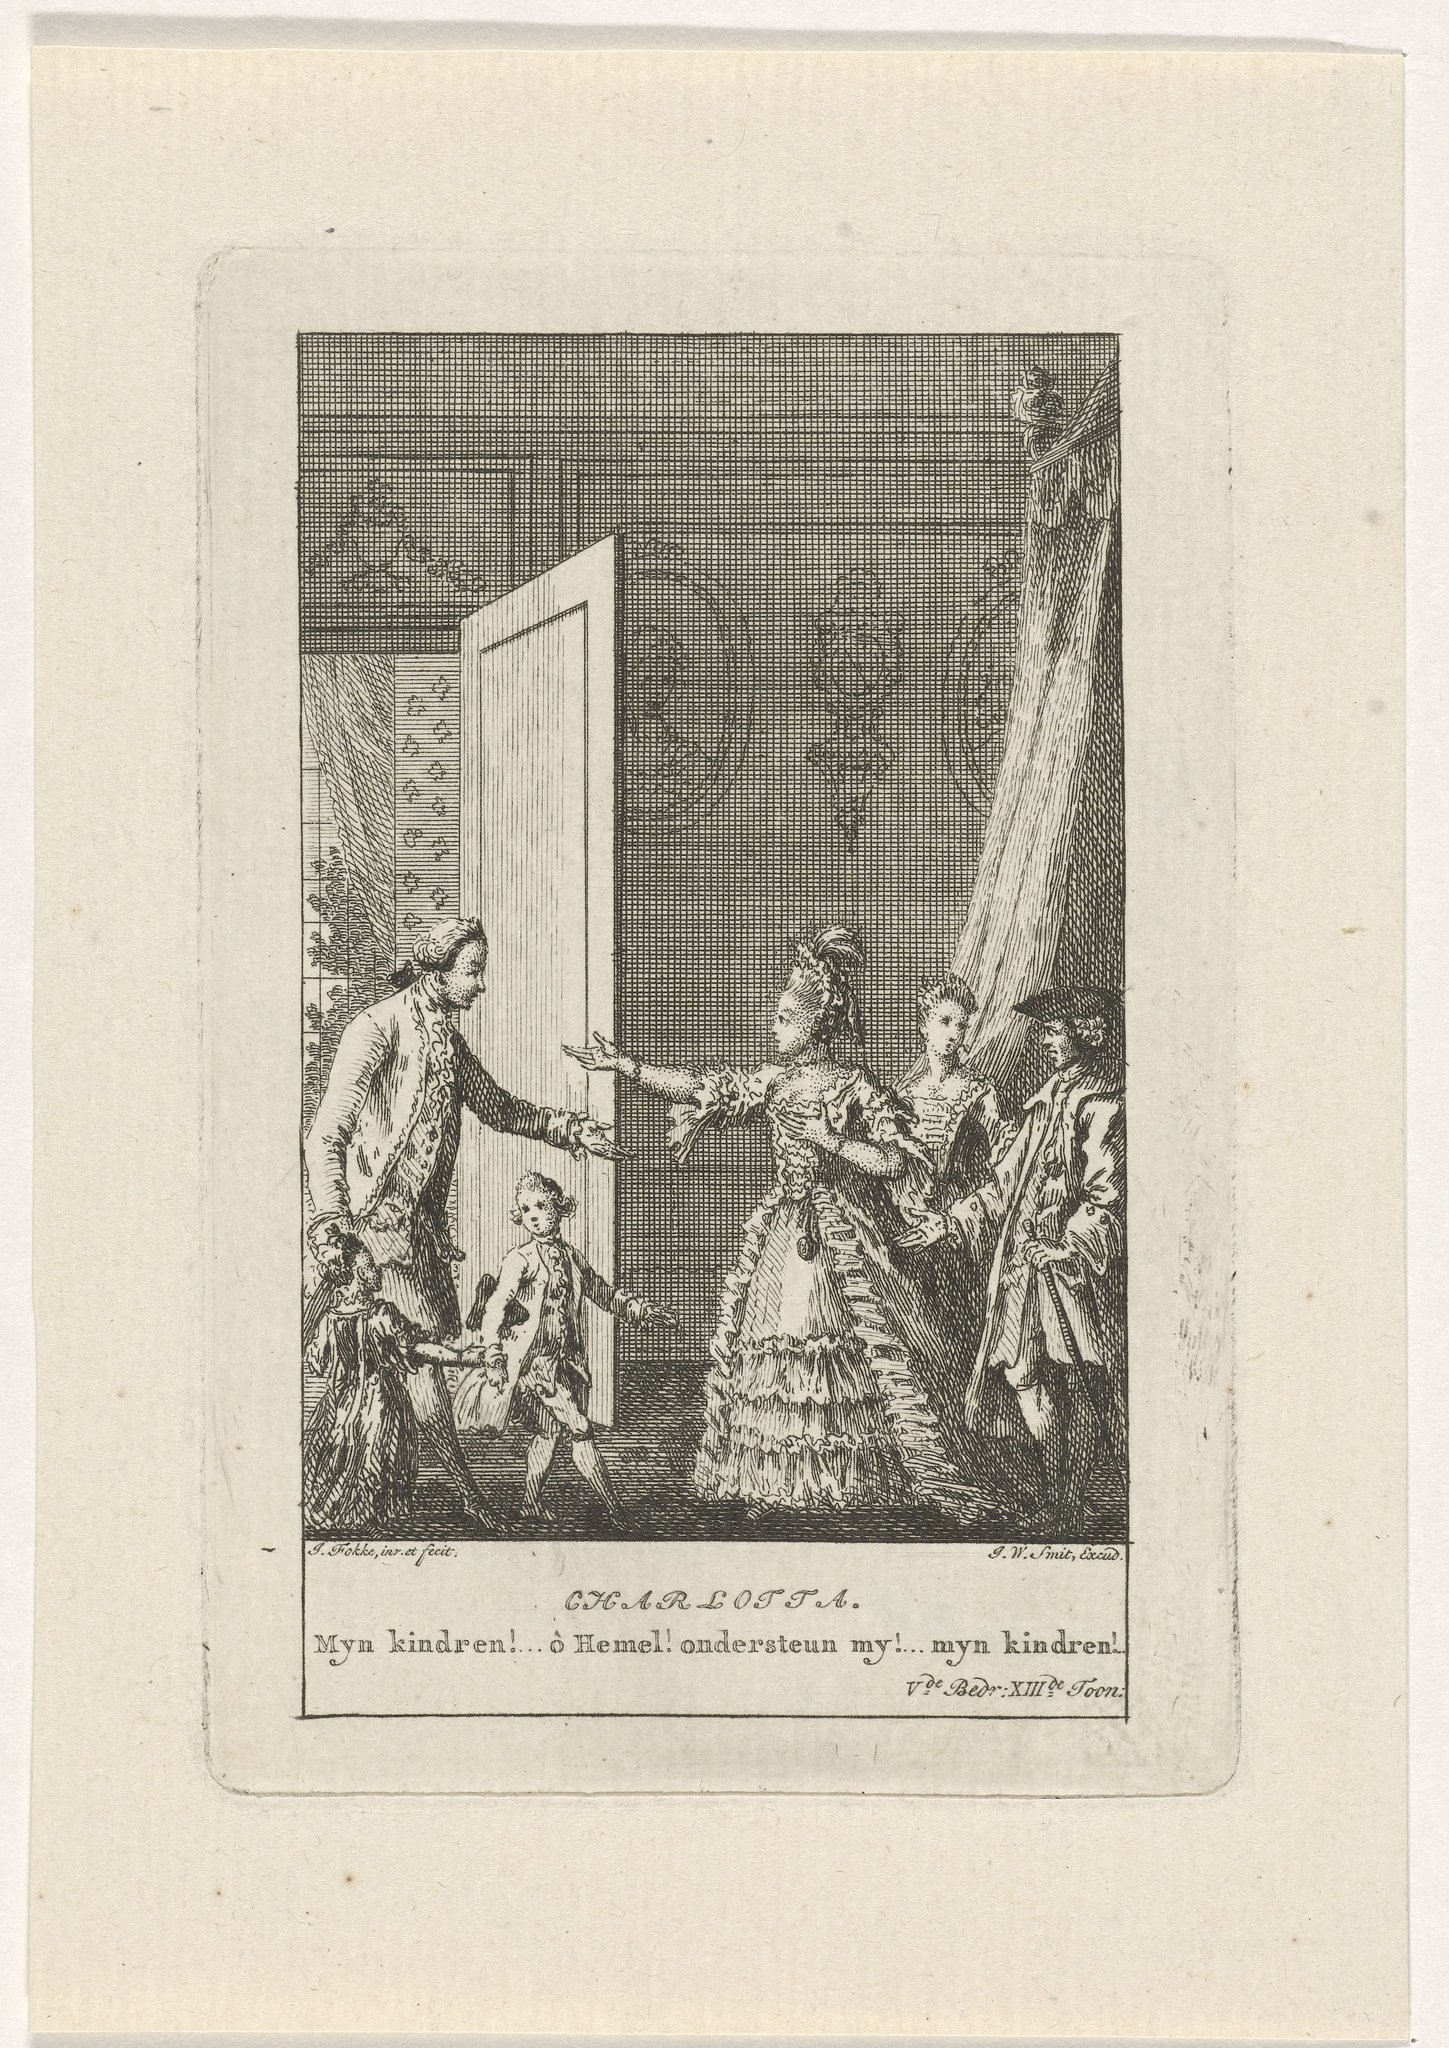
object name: print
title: Charlotta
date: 1778-1812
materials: paper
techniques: etching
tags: visiting; receiving guests; elegant company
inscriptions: collector's mark: Lugt 2228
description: In een vertrek ontvangt een dame een heer en twee kleine kinderen. Deze prent is vervaardigd voor een onbekend toneelstuk. In de marge staat een regel tekst, rechtsonder gemerkt: Vde Bedr: XIIIde Toon.